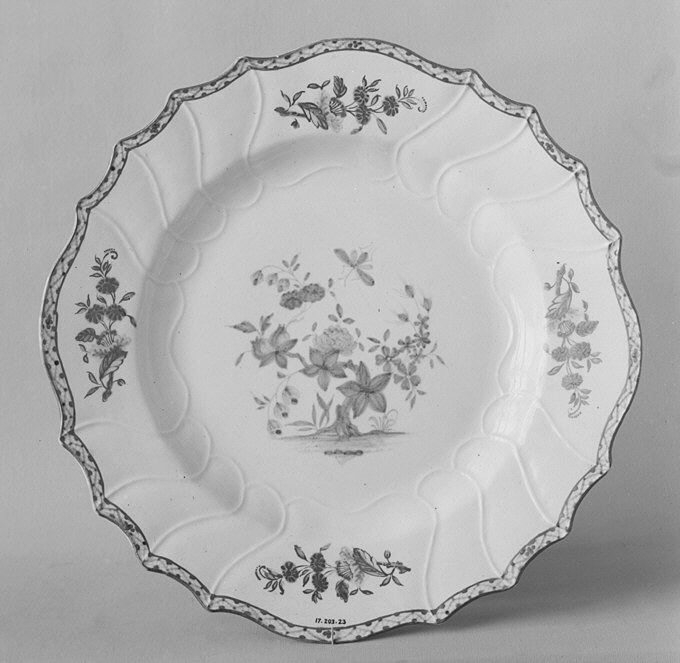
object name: dish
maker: tournai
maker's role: factory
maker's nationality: belgian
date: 1762-1775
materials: soft paste porcelain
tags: flowers